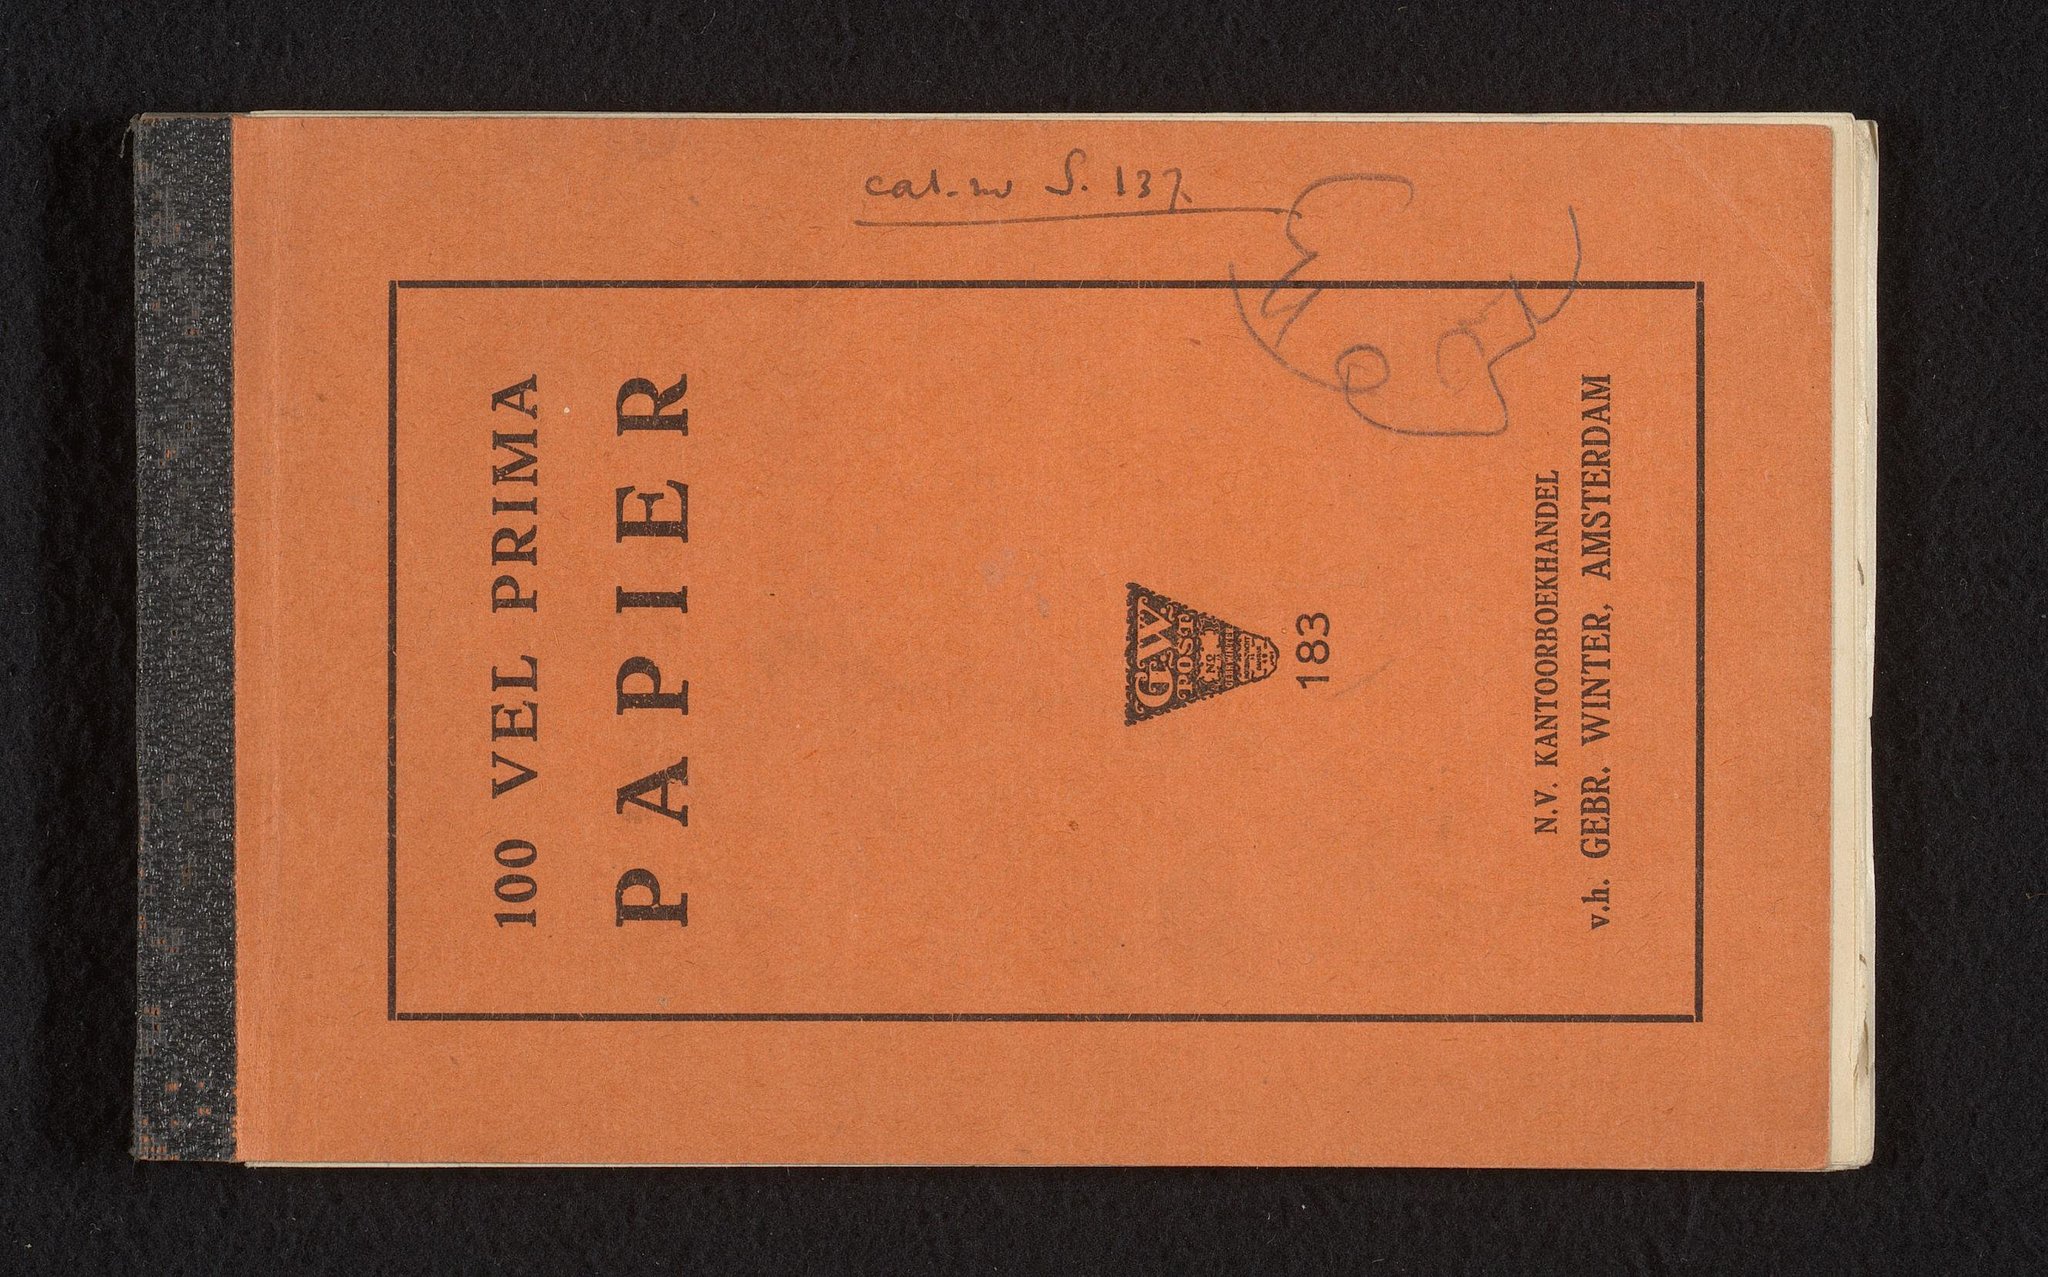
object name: sketchbook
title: Schetsboek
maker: leo gestel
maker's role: draughtsman, print maker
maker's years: 1881-1941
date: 1925-1941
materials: ink, paper, pencil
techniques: drawing, pen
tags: clown, horses (circus performance)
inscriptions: workshop stamp: Lugt 1078a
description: Schetsboek met 57 tekeningen waarvan 24 op losse bladen: studies van (circus)paarden, clowns en clowns als paardendresseur.